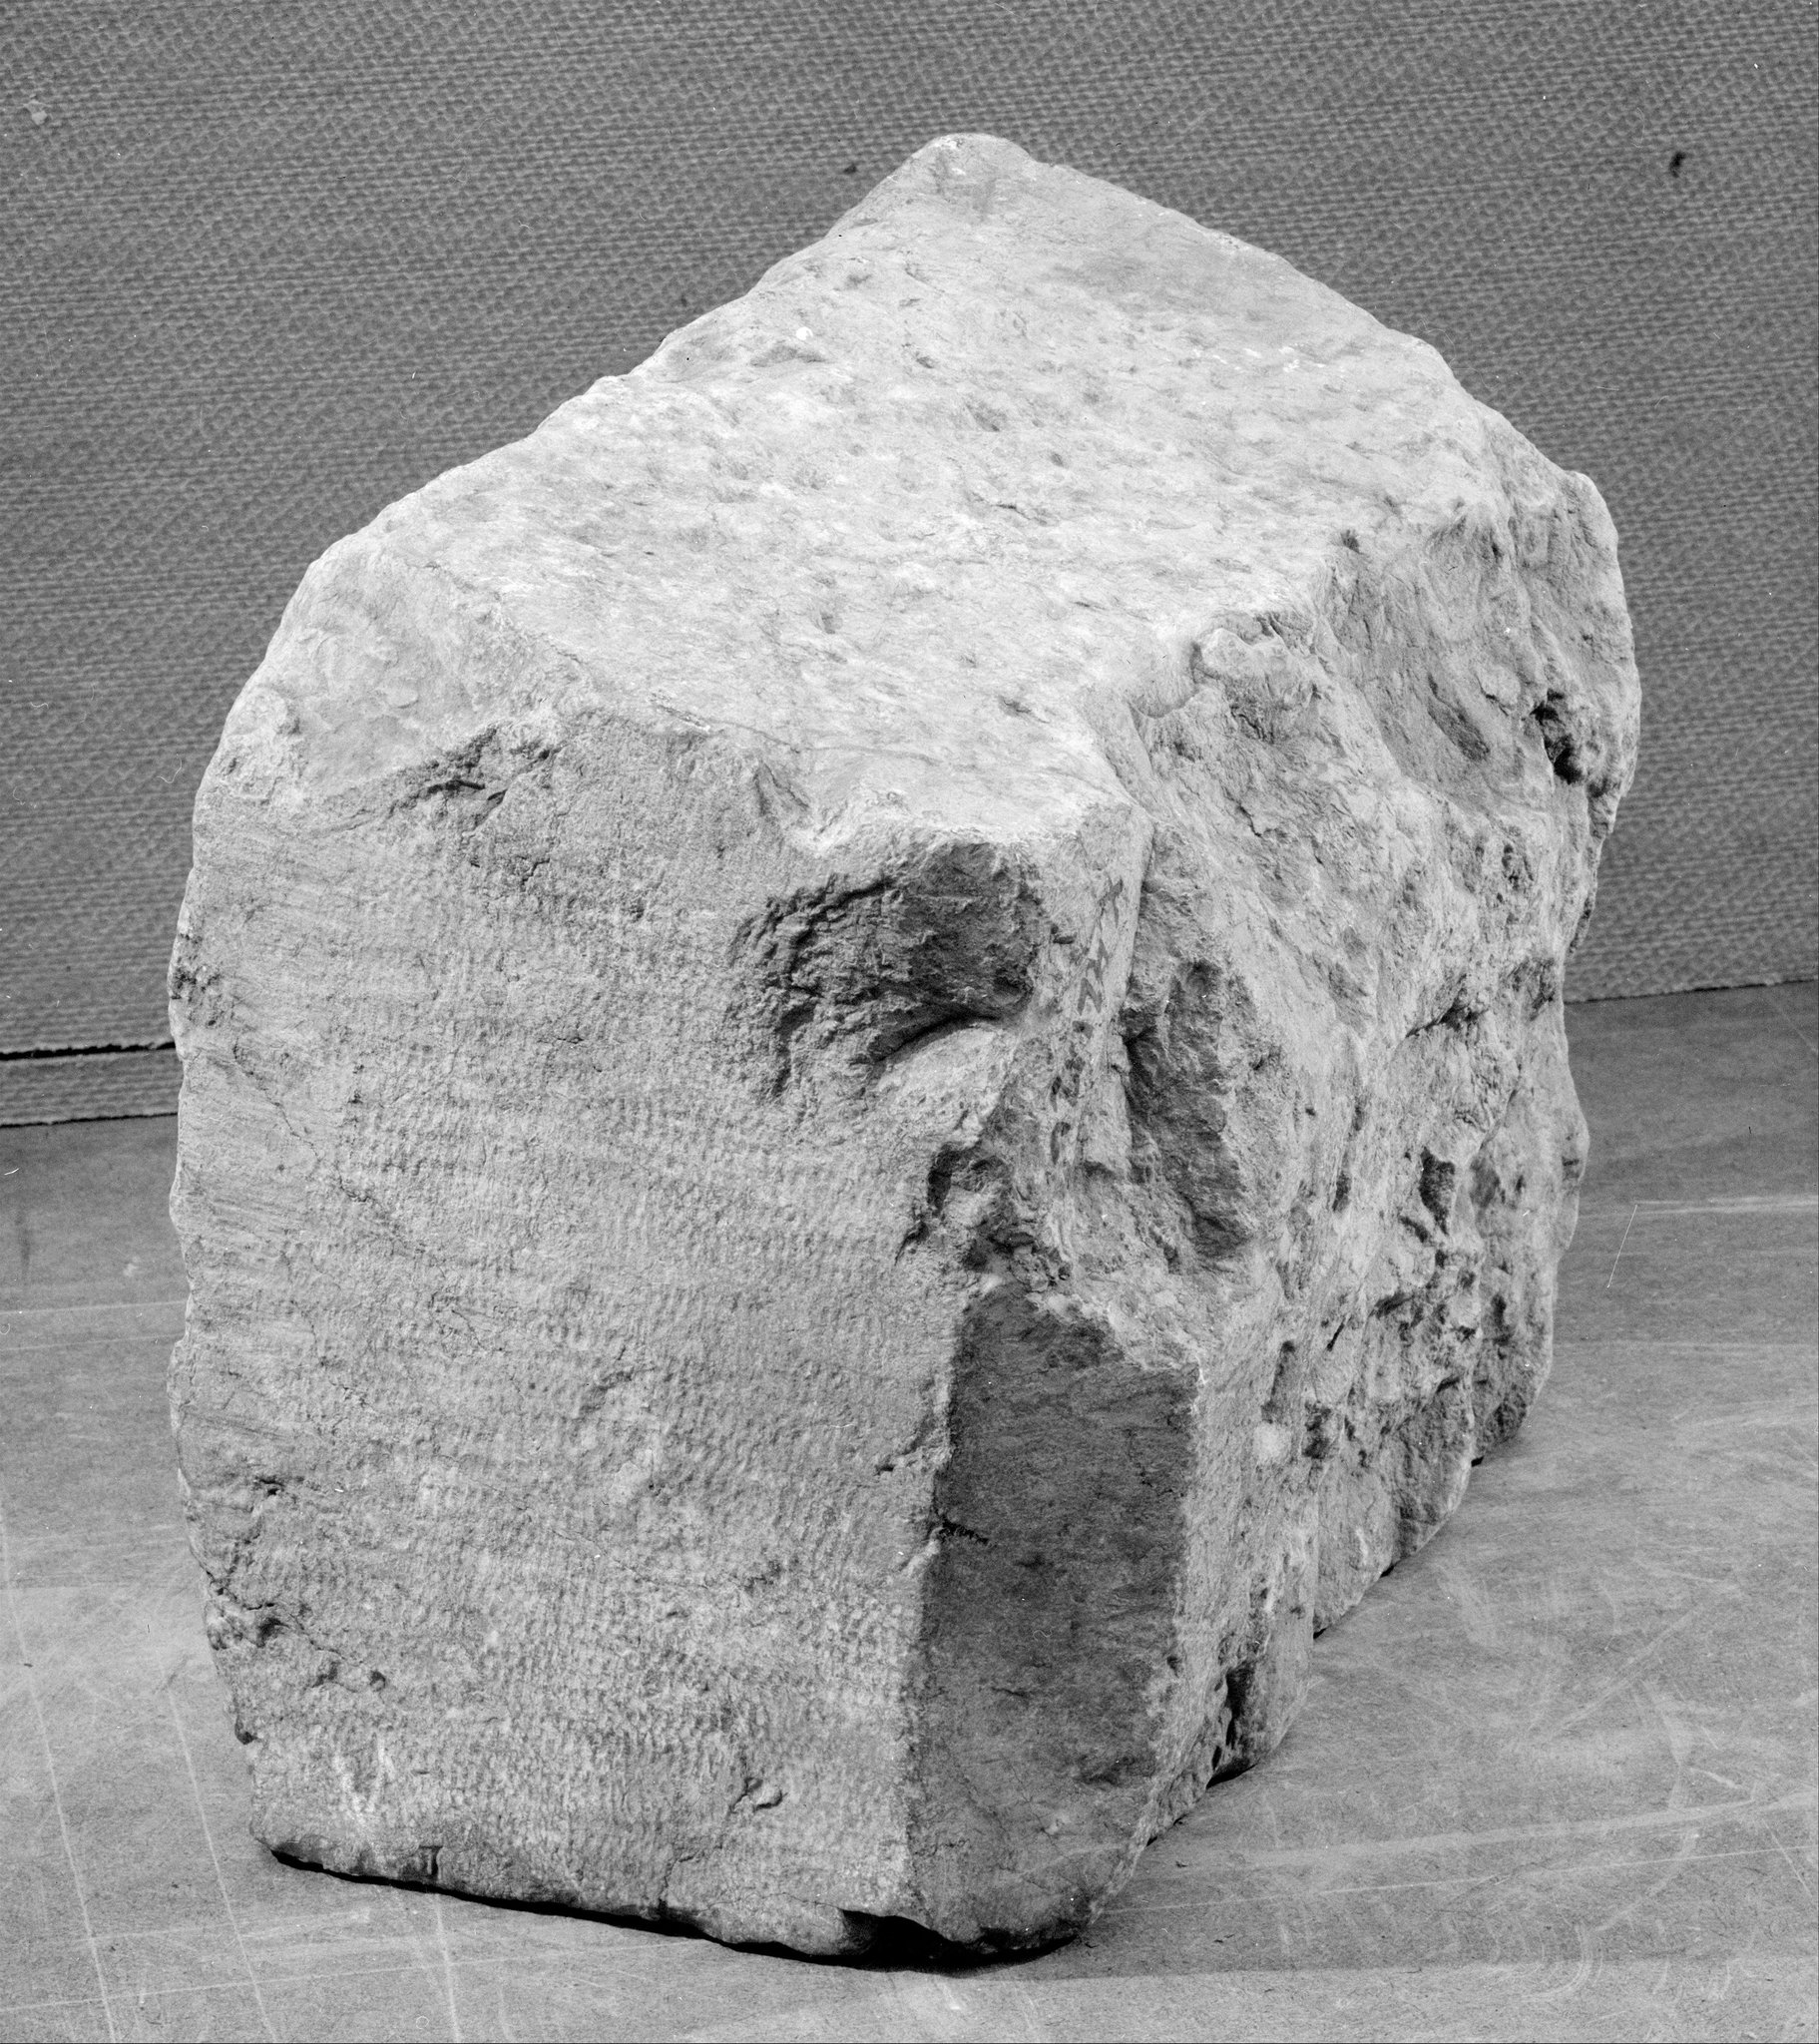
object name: block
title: Block Fragment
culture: french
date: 1130-1140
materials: stone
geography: france